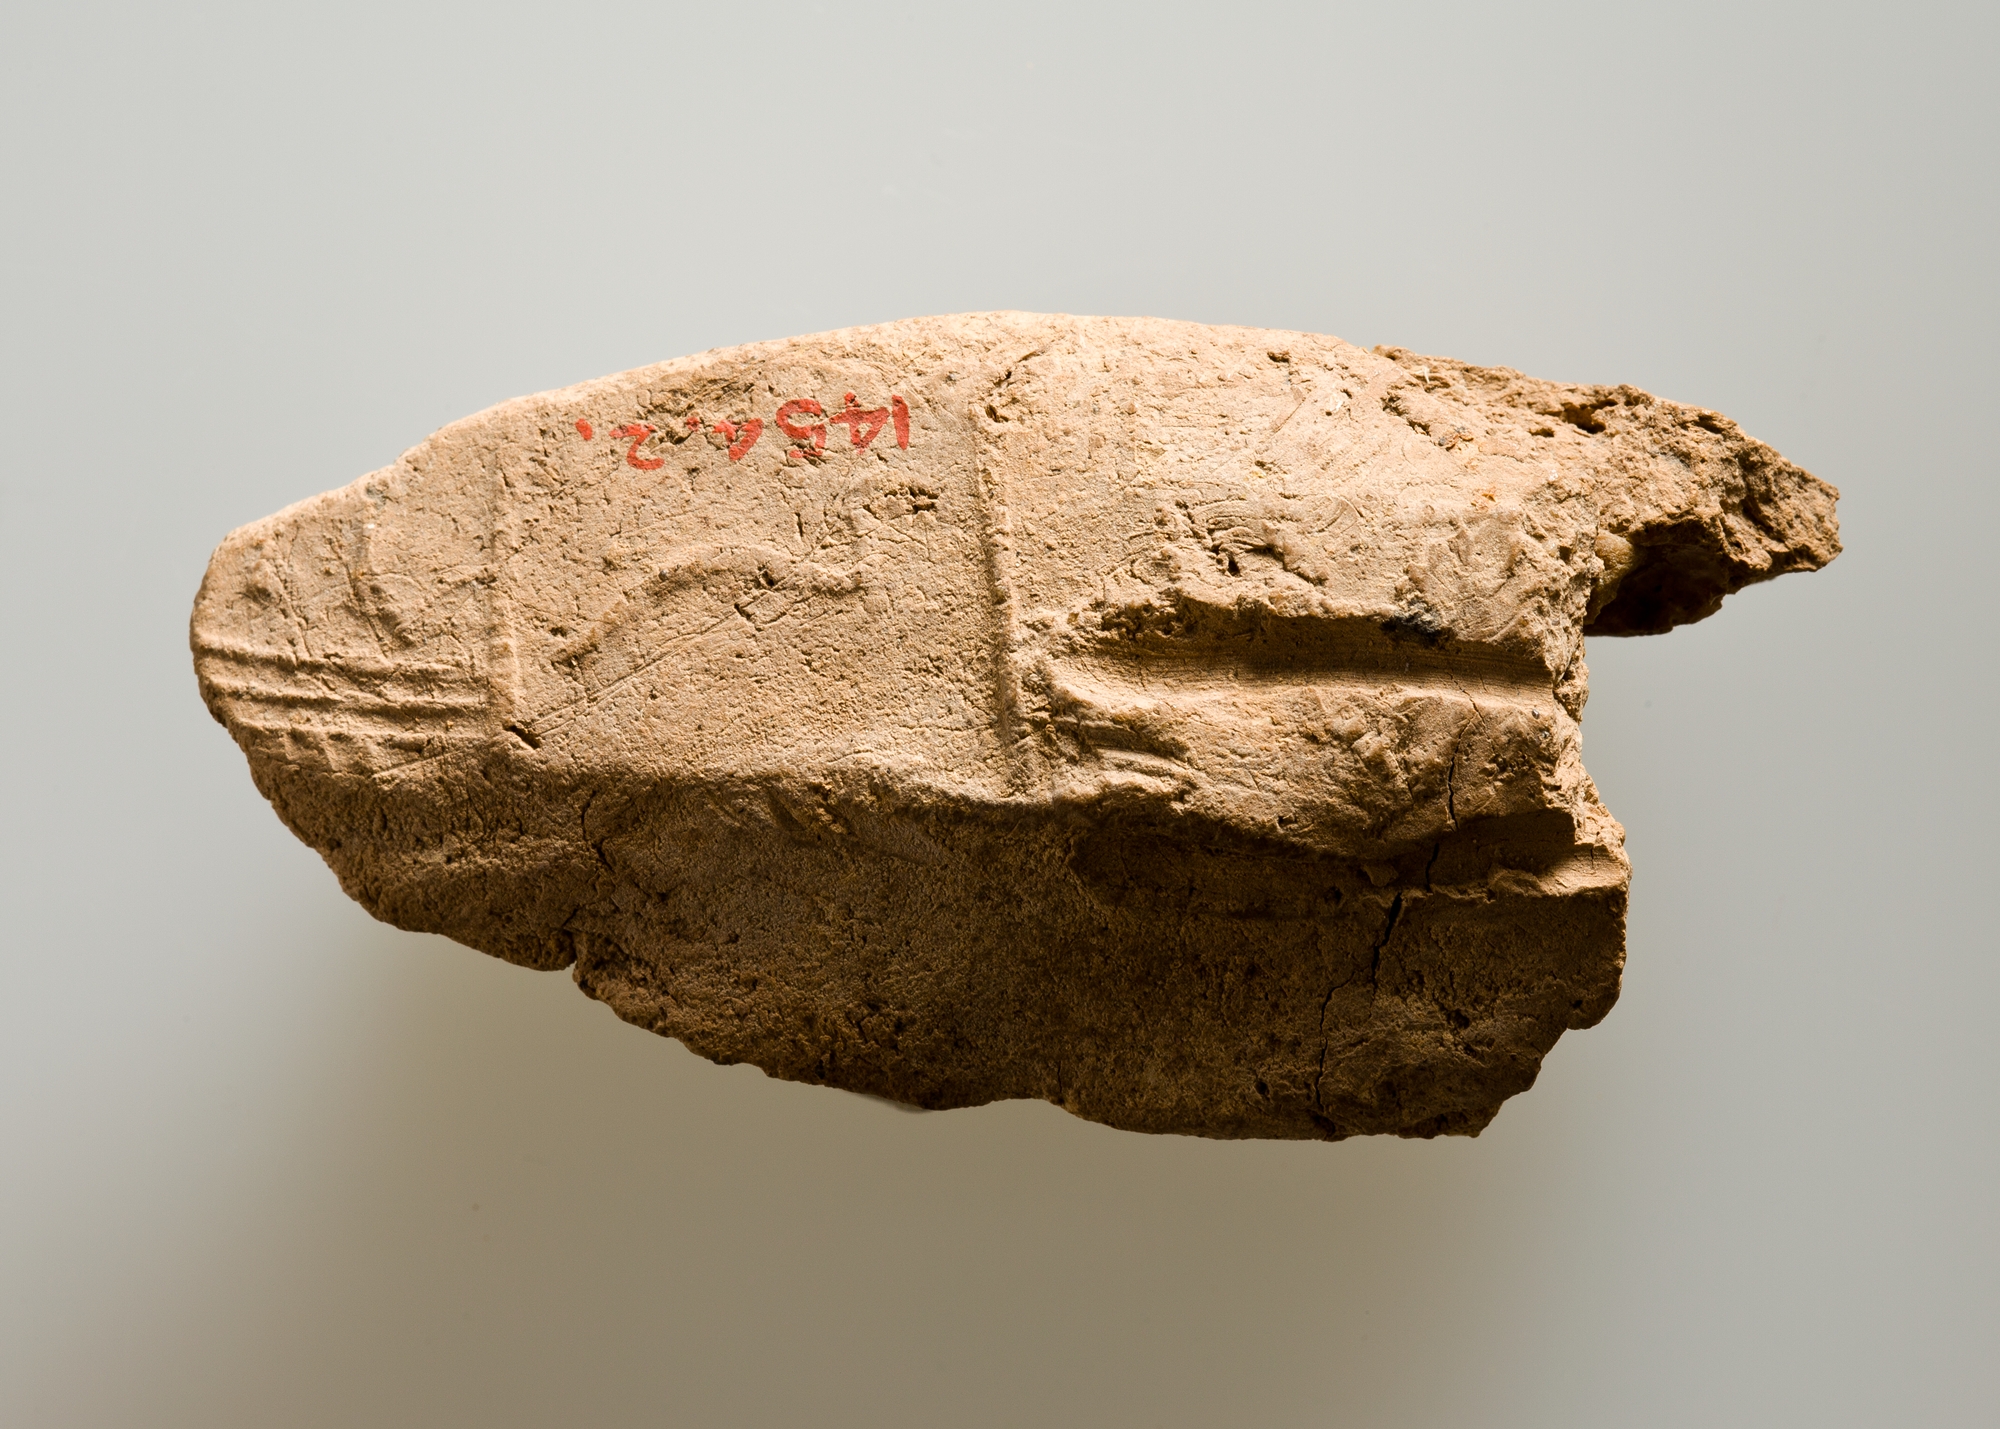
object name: sealing, jar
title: Clay jar sealing impressed faintly with name of Khasekhemwy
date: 2650 BCE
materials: clay